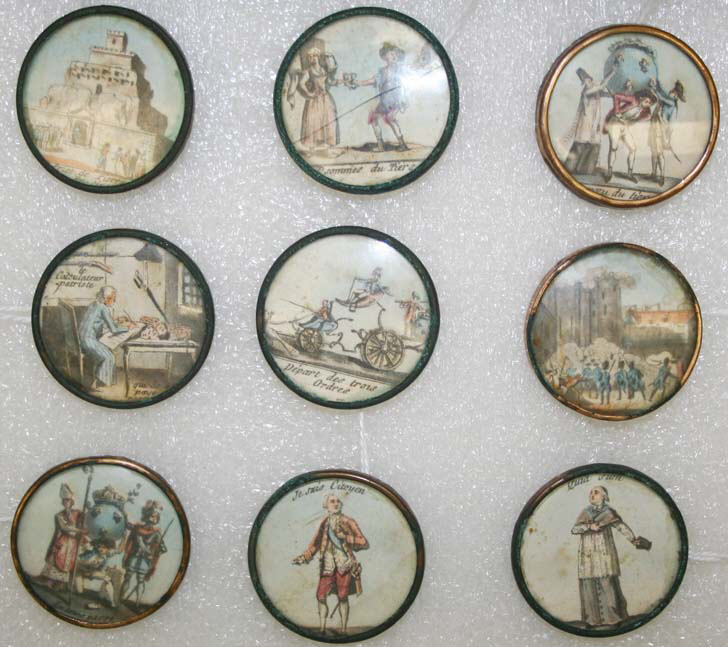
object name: button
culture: french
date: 1780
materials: glass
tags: men,women,chariots